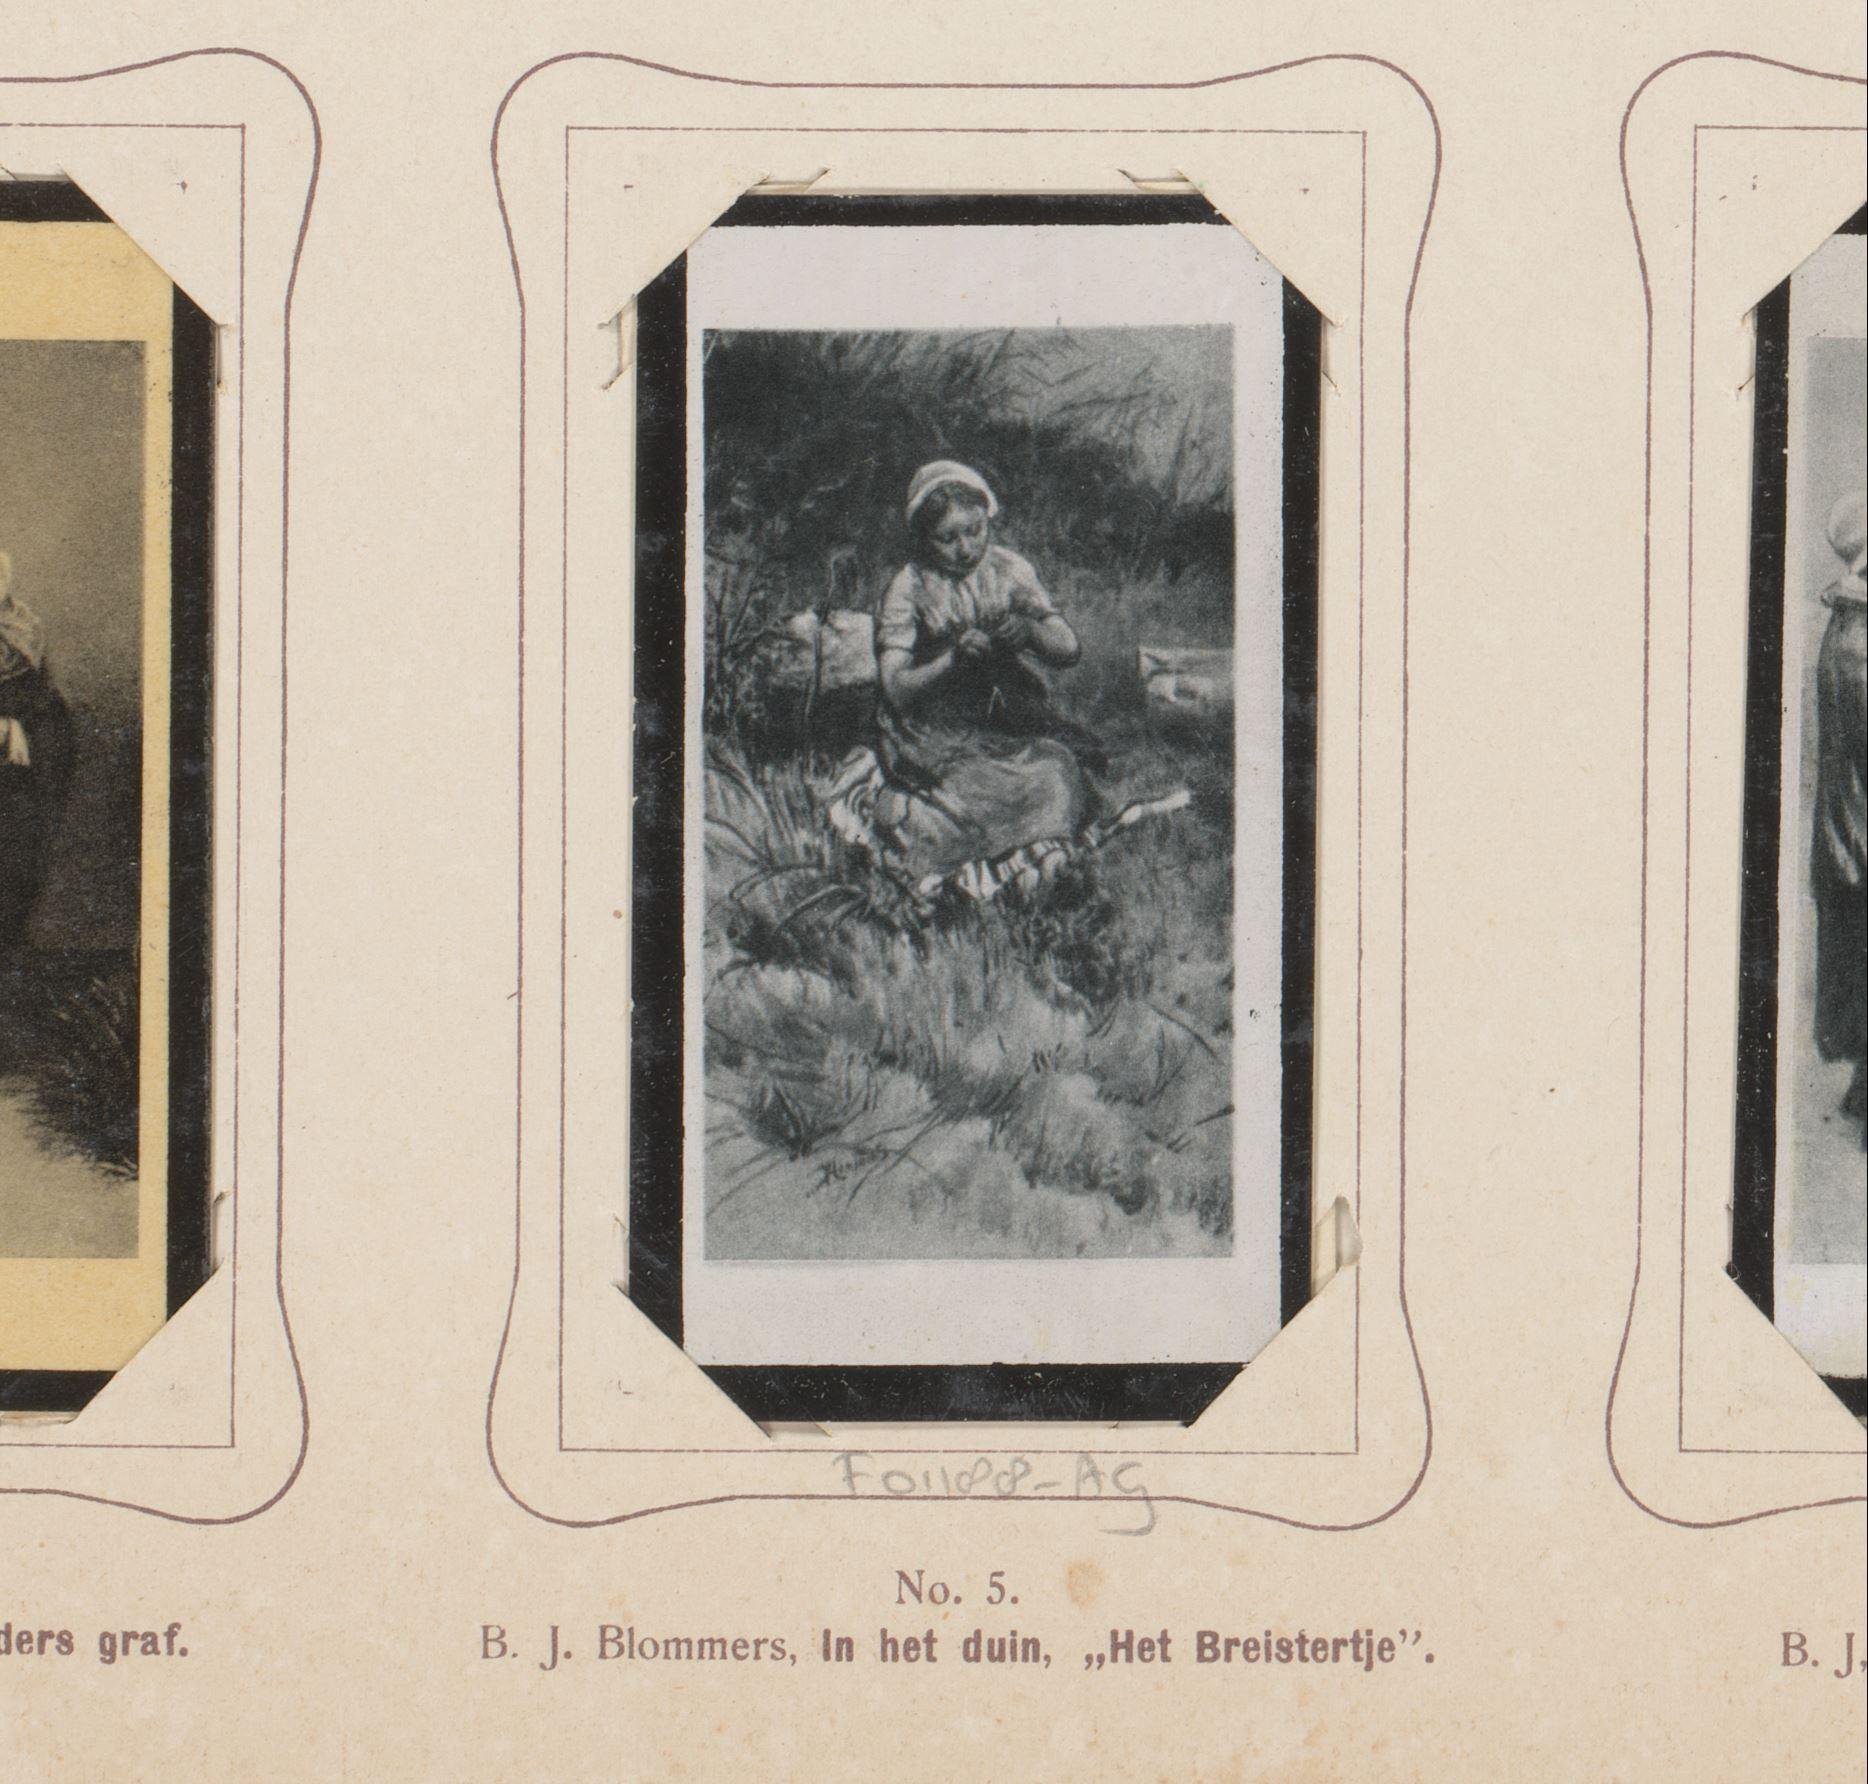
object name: reproduction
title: Reproductie van een schilderij van een breiend meisje in de duinen naar Bart Johannes Blommers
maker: Anonymous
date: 1906-1907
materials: paper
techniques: photograph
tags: dunes (sea not visible); in the dunes, girl (child between toddler and youth), knitting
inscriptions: inscription: ‘No. 5./ B.J. Blommers, In het duin, "het breistertje".’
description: Deze prent maakt deel uit van een album.